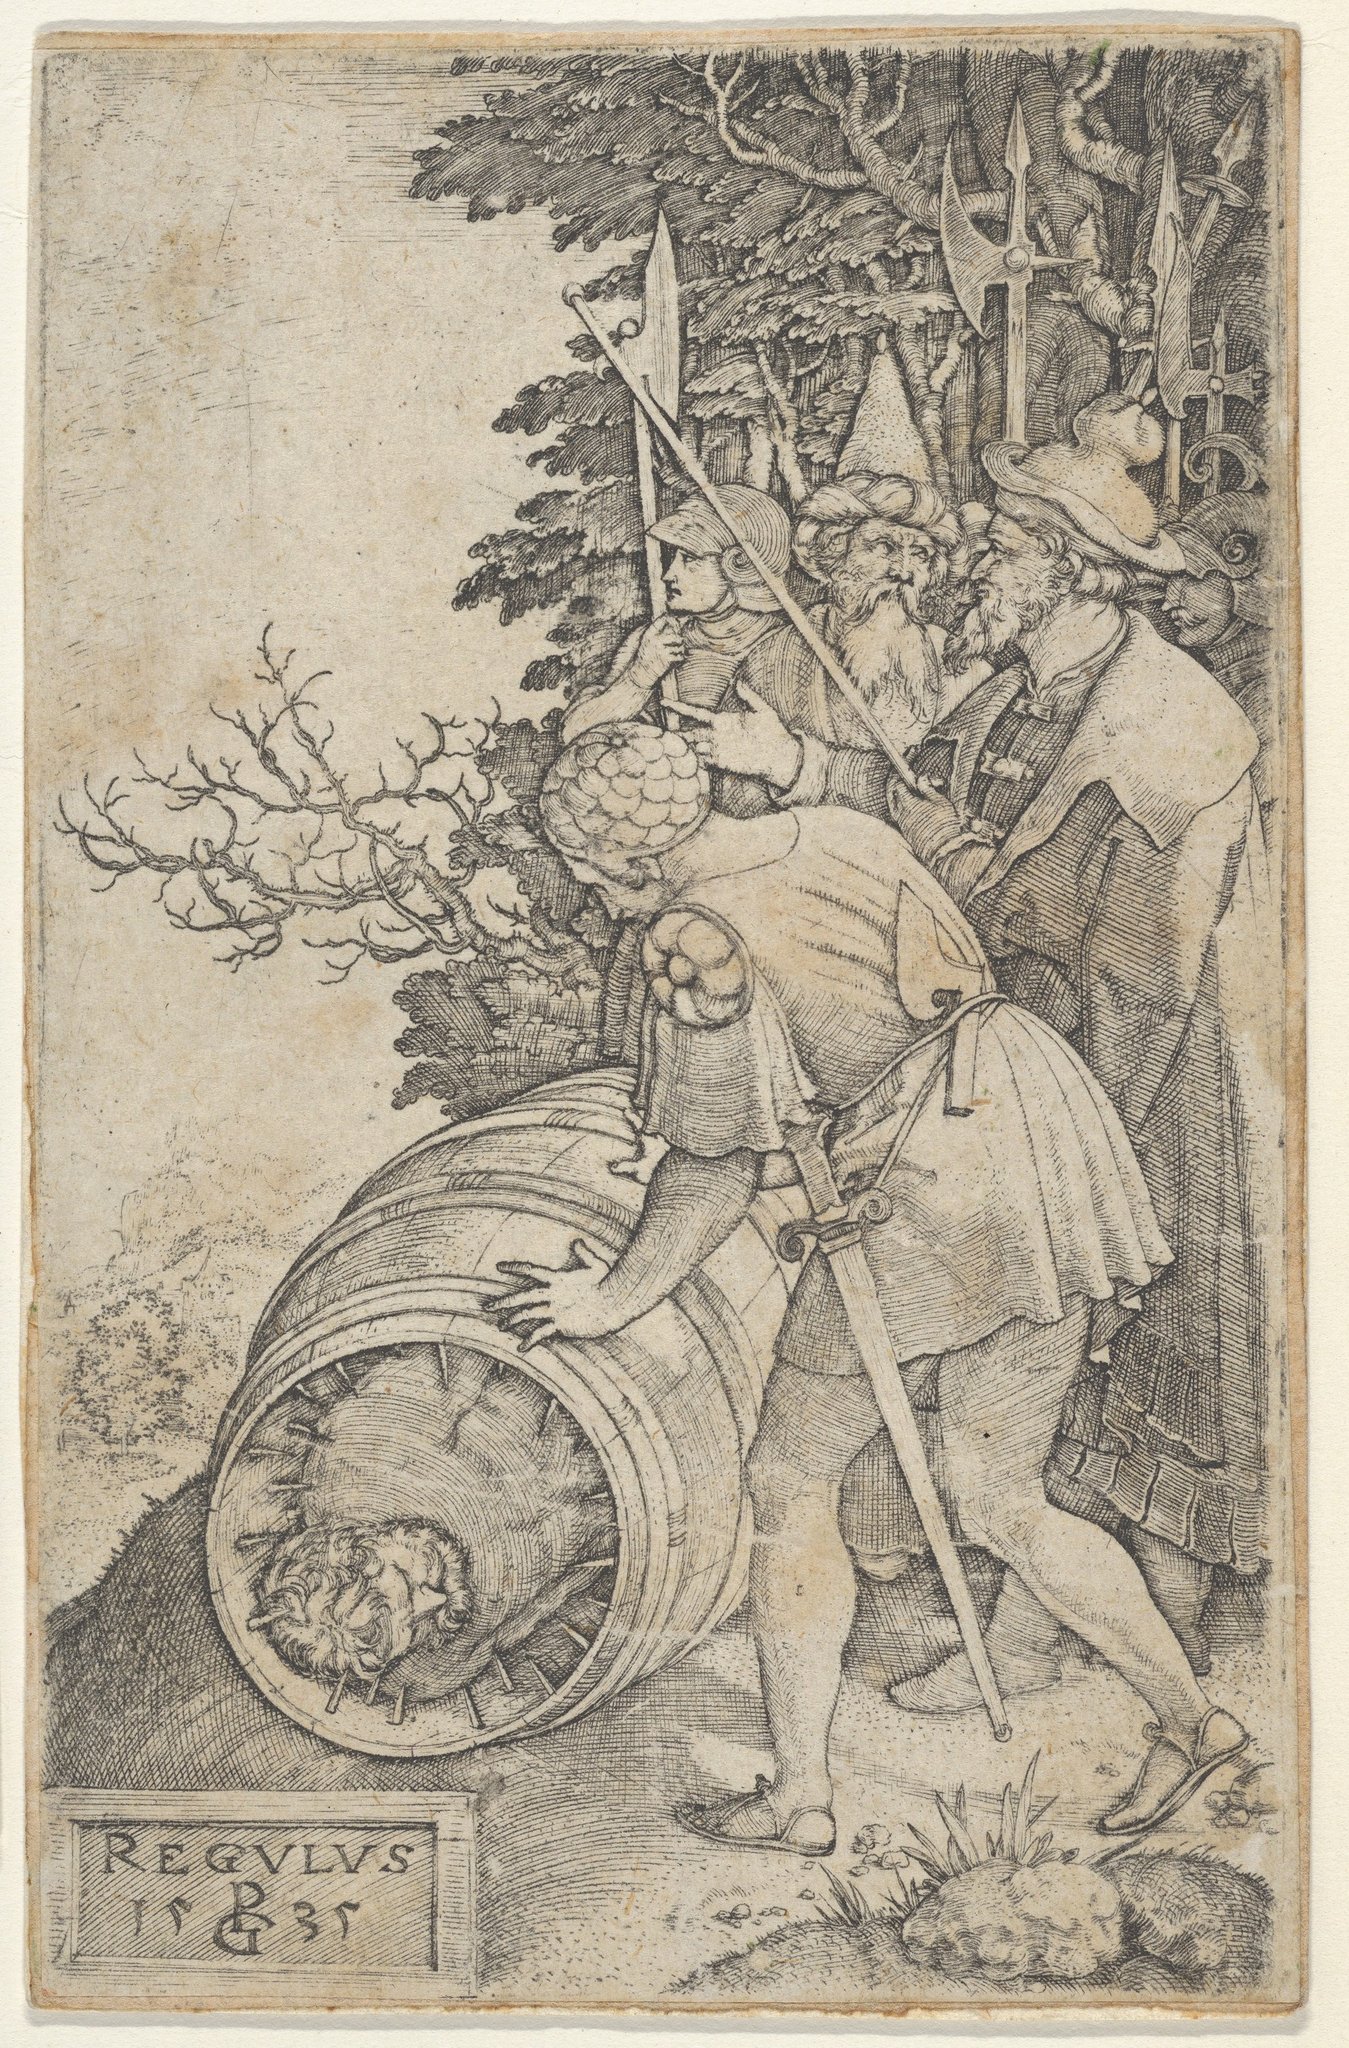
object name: print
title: Copy of Attilius Regulus, from "Roman Heroes"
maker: georg pencz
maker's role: artist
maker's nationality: german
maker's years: 1500-1550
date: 1535-1600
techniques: engraving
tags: swords,men,punishment